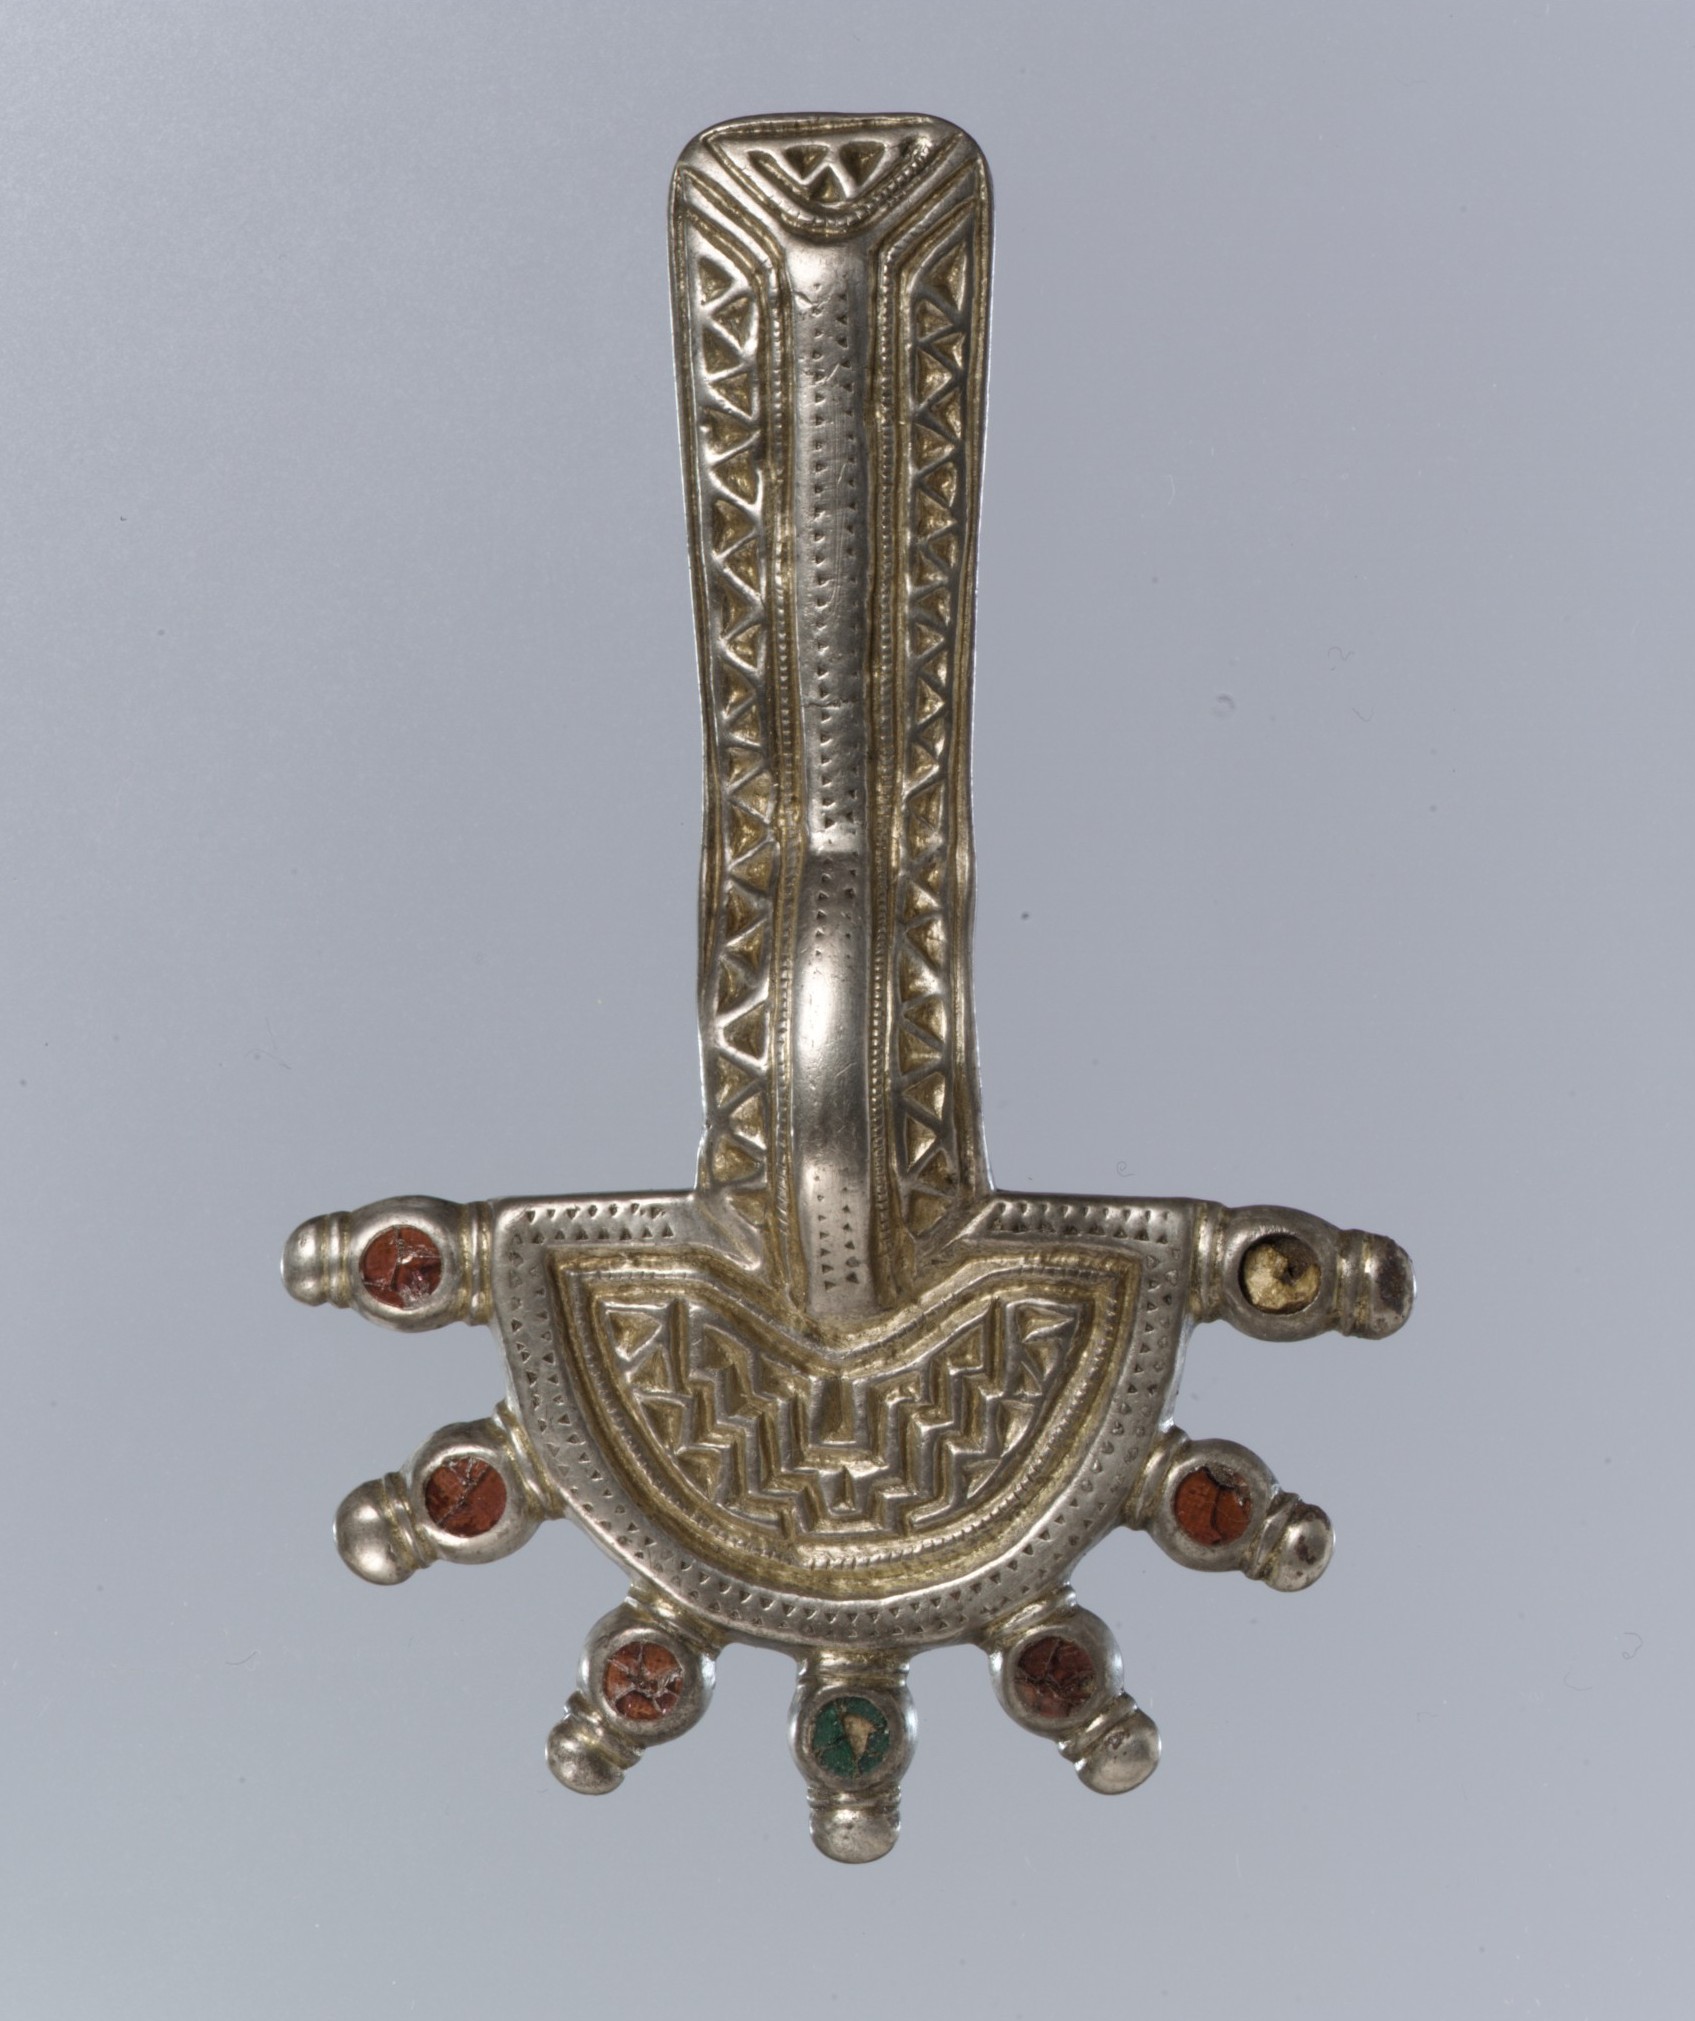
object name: brooch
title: Bow Brooch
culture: frankish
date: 500-550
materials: gemstone, glass, niello, silver gilt